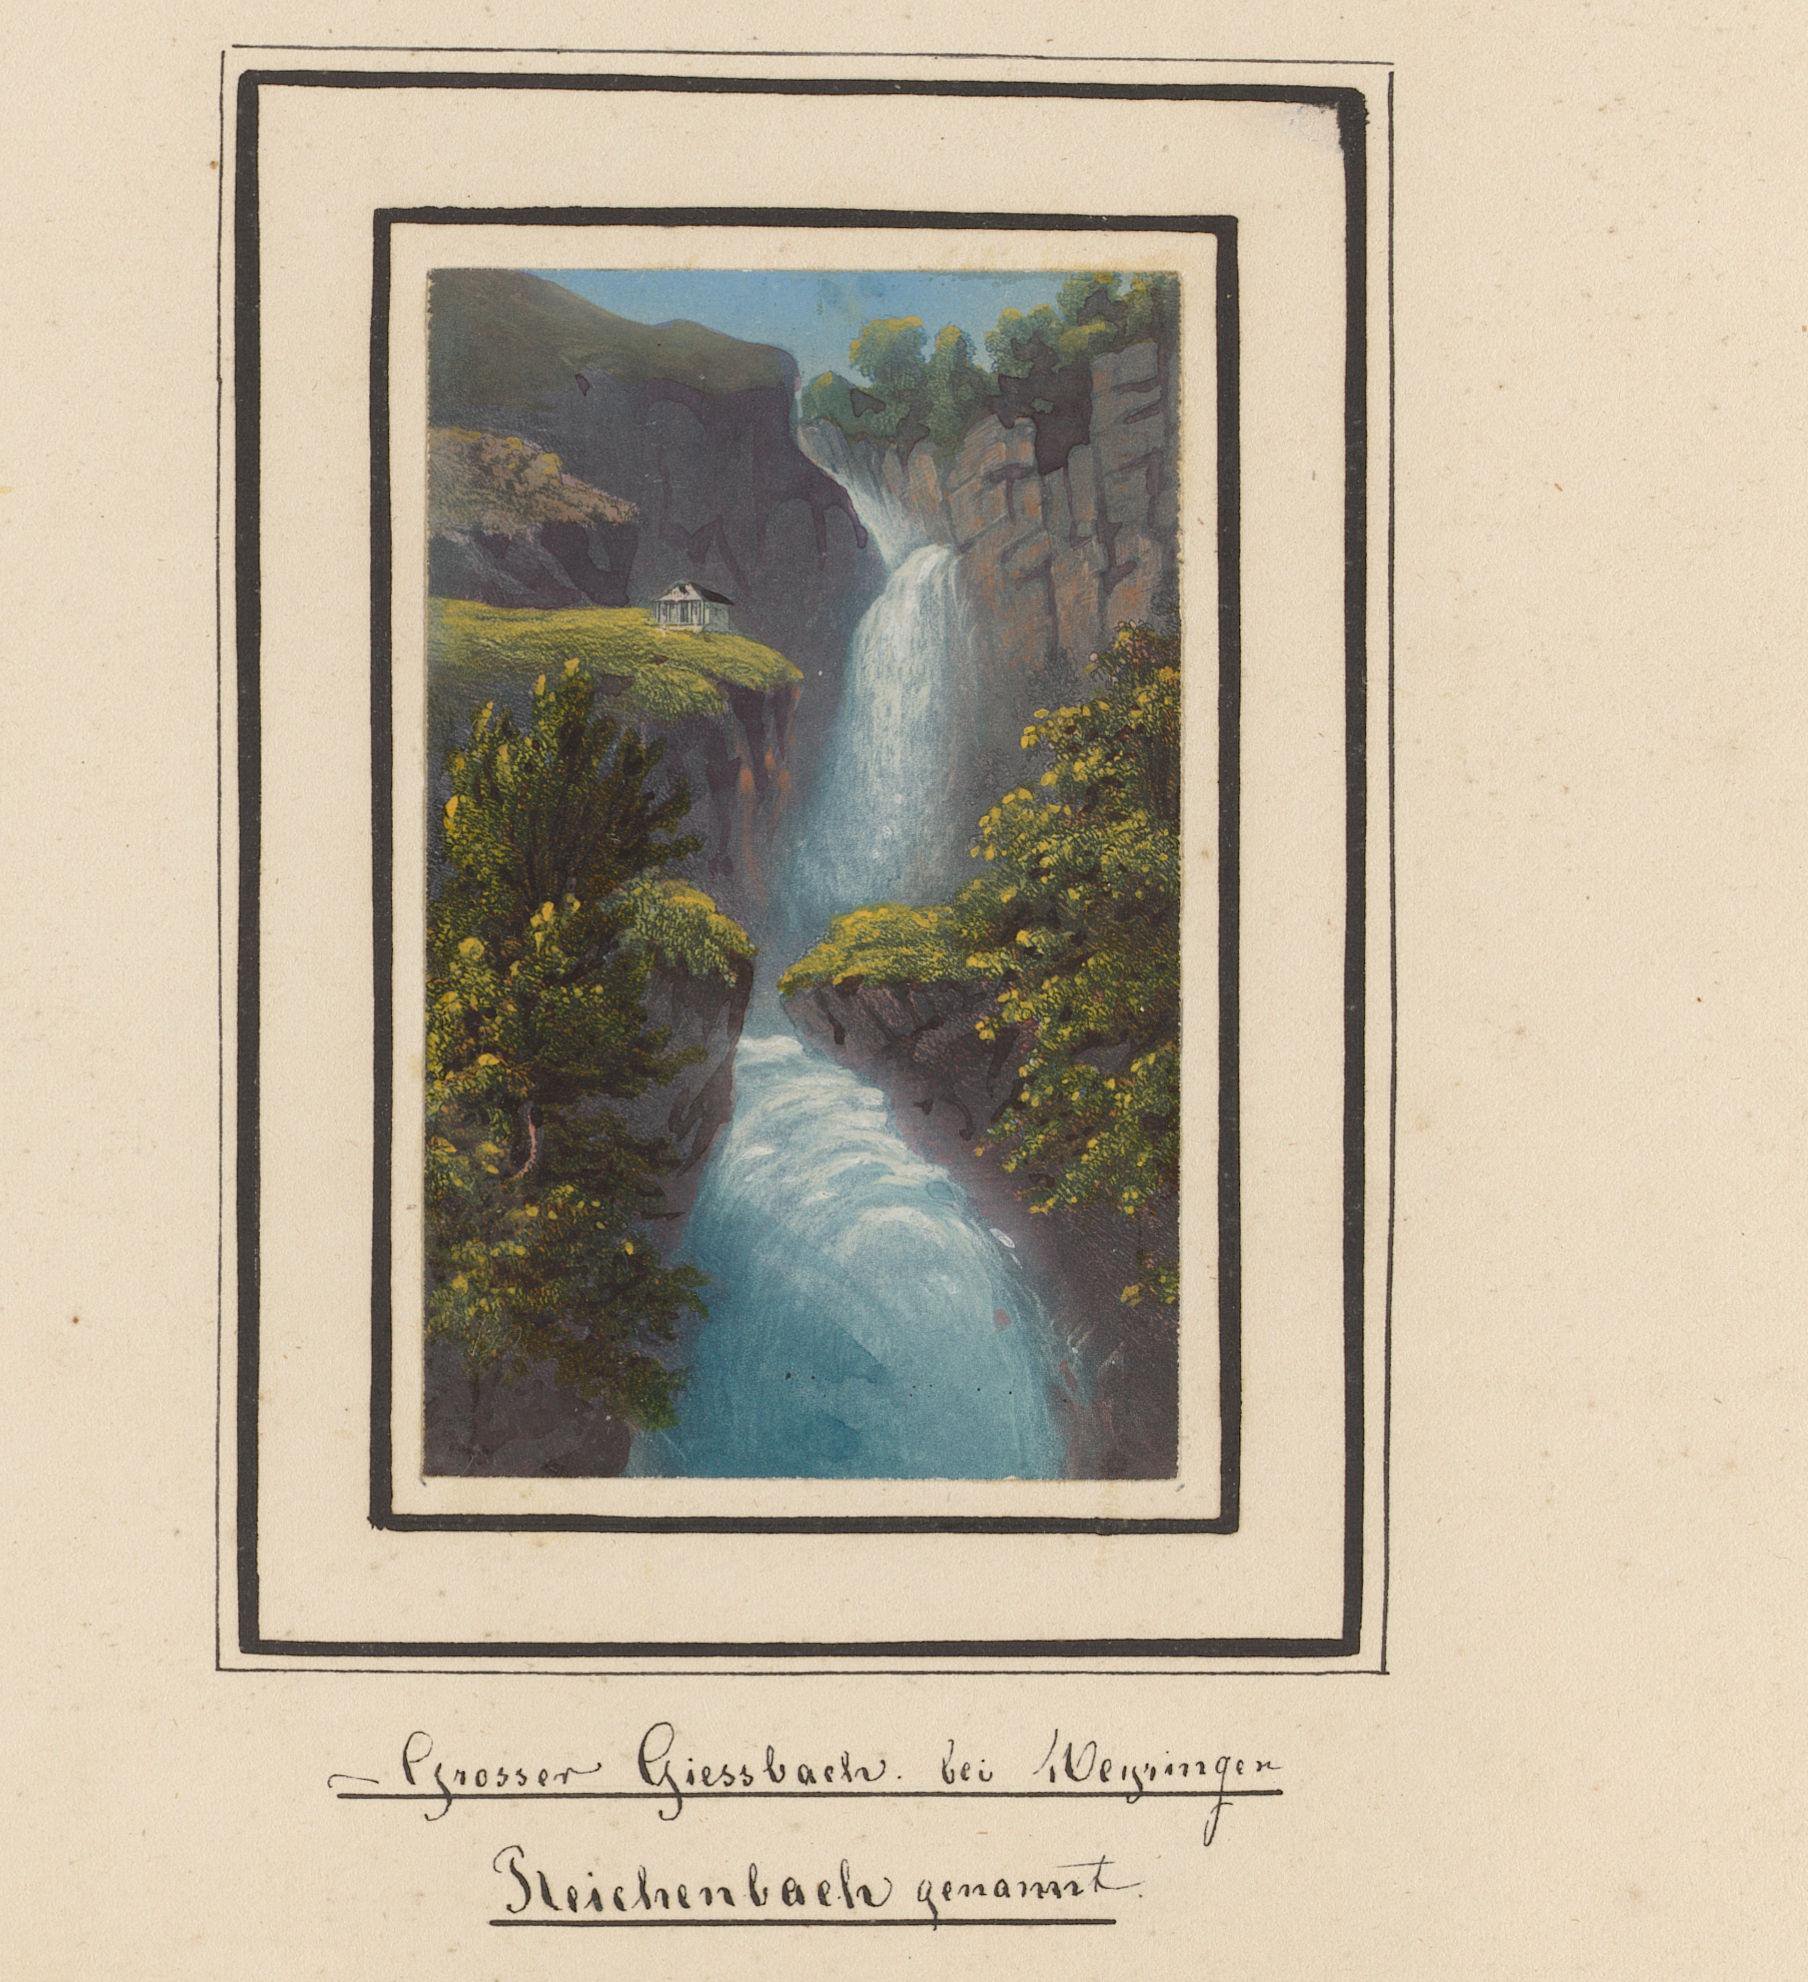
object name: photomechanical print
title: Reichenbachwaterval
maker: Anonymous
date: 1870-1890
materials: paper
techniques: photograph, hand coloring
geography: reichenbachwaterval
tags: waterfall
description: Deze prent maakt deel uit van een album.